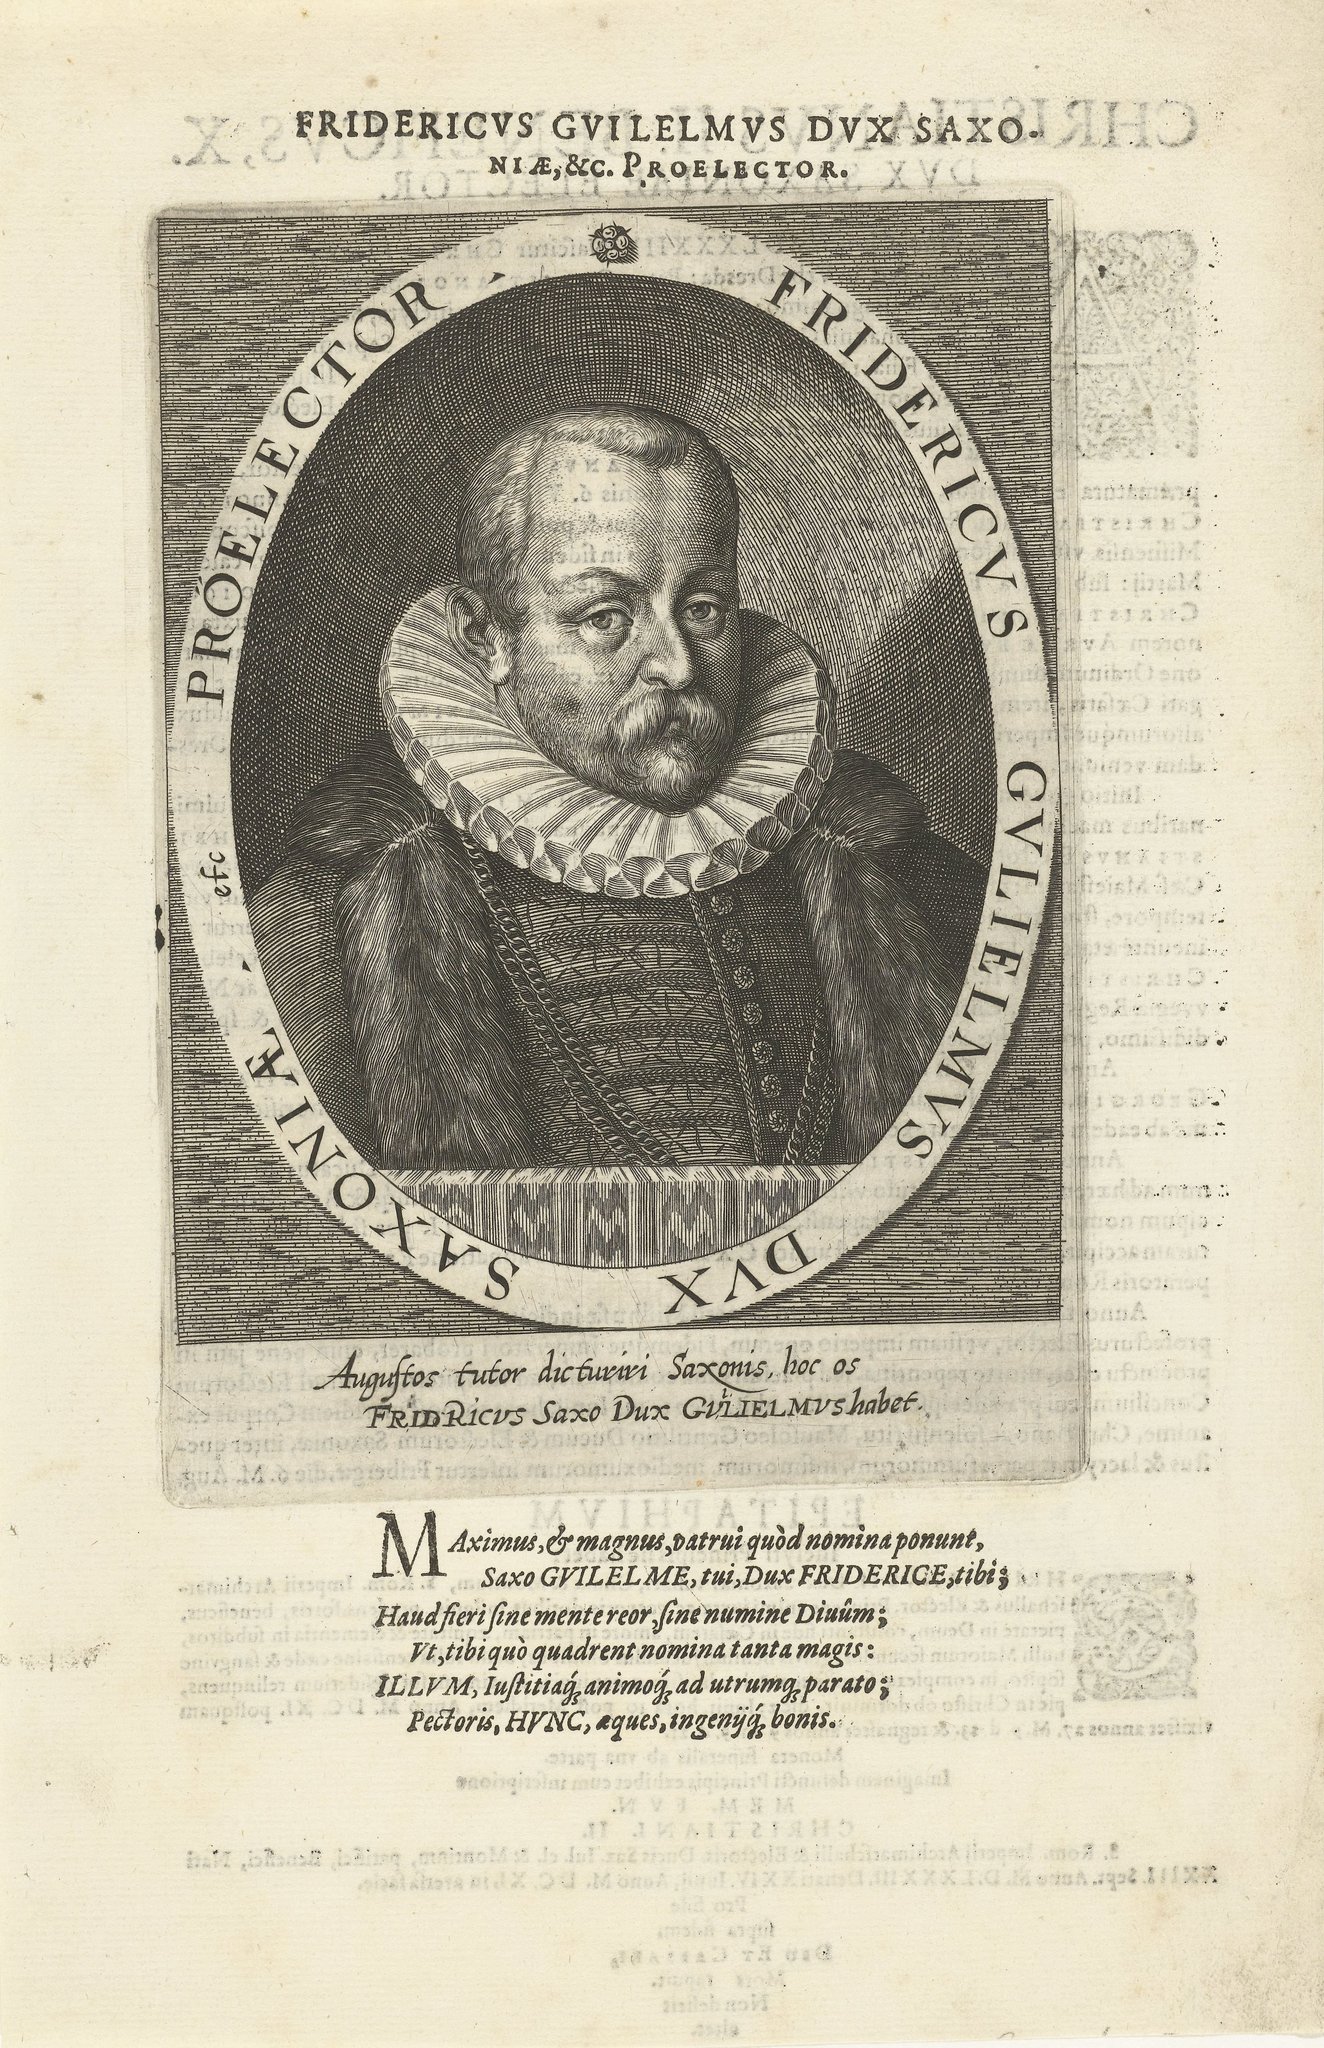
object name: print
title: Portret van Friedrich Wilhelm van Saksen-Altenburg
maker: dominicus custos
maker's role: print maker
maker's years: 1560-1615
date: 1601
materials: paper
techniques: engraving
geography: augsburg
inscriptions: collector's mark: Lugt 2228